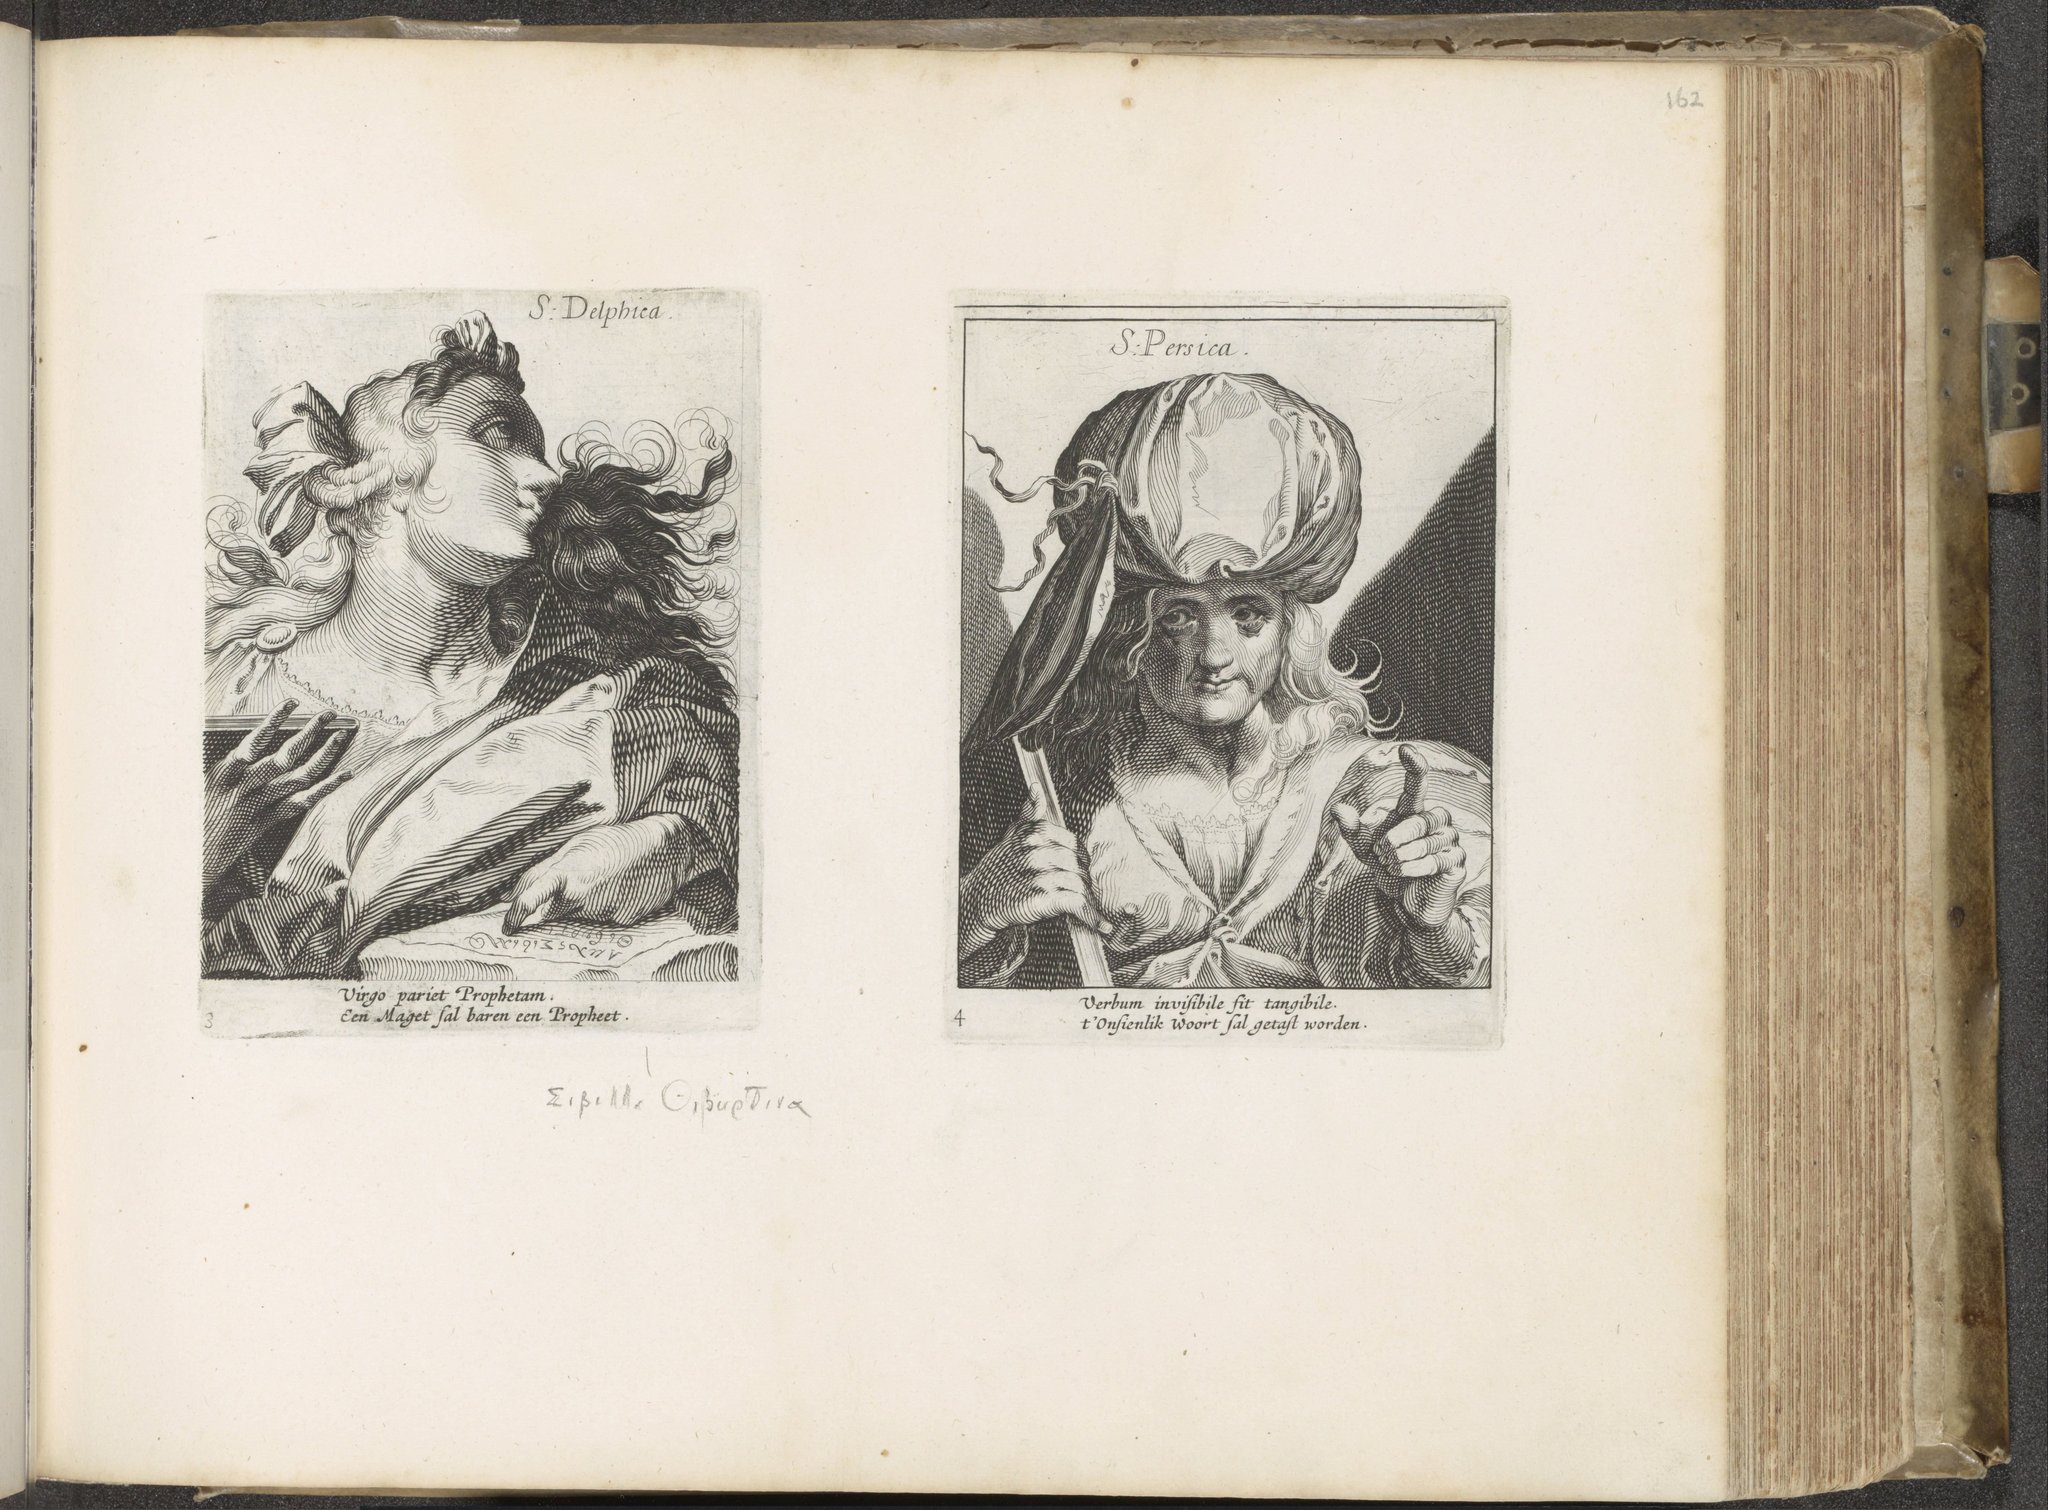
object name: print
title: Sibille van Delphi / Sibille van Perzië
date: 1580-1628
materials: paper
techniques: engraving, etching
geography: amsterdam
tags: sibyls (with name), persian sibyl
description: Twee voorstellingen op een albumblad. Links de Sibille van Delphi, ten halven lijve, met boek. Met haar linkerhand wijst ze op een inscriptie in steen. Links de Sibille van Perzië, wederom met een boek. Ze draagt een tulband op haar hoofd. Met haar linkerhand wijst ze omhoog. In de ondermarge van beide voorstellingen een tekstregel in het Latijn en het Nederlands. Het blad maakt deel uit van een album.